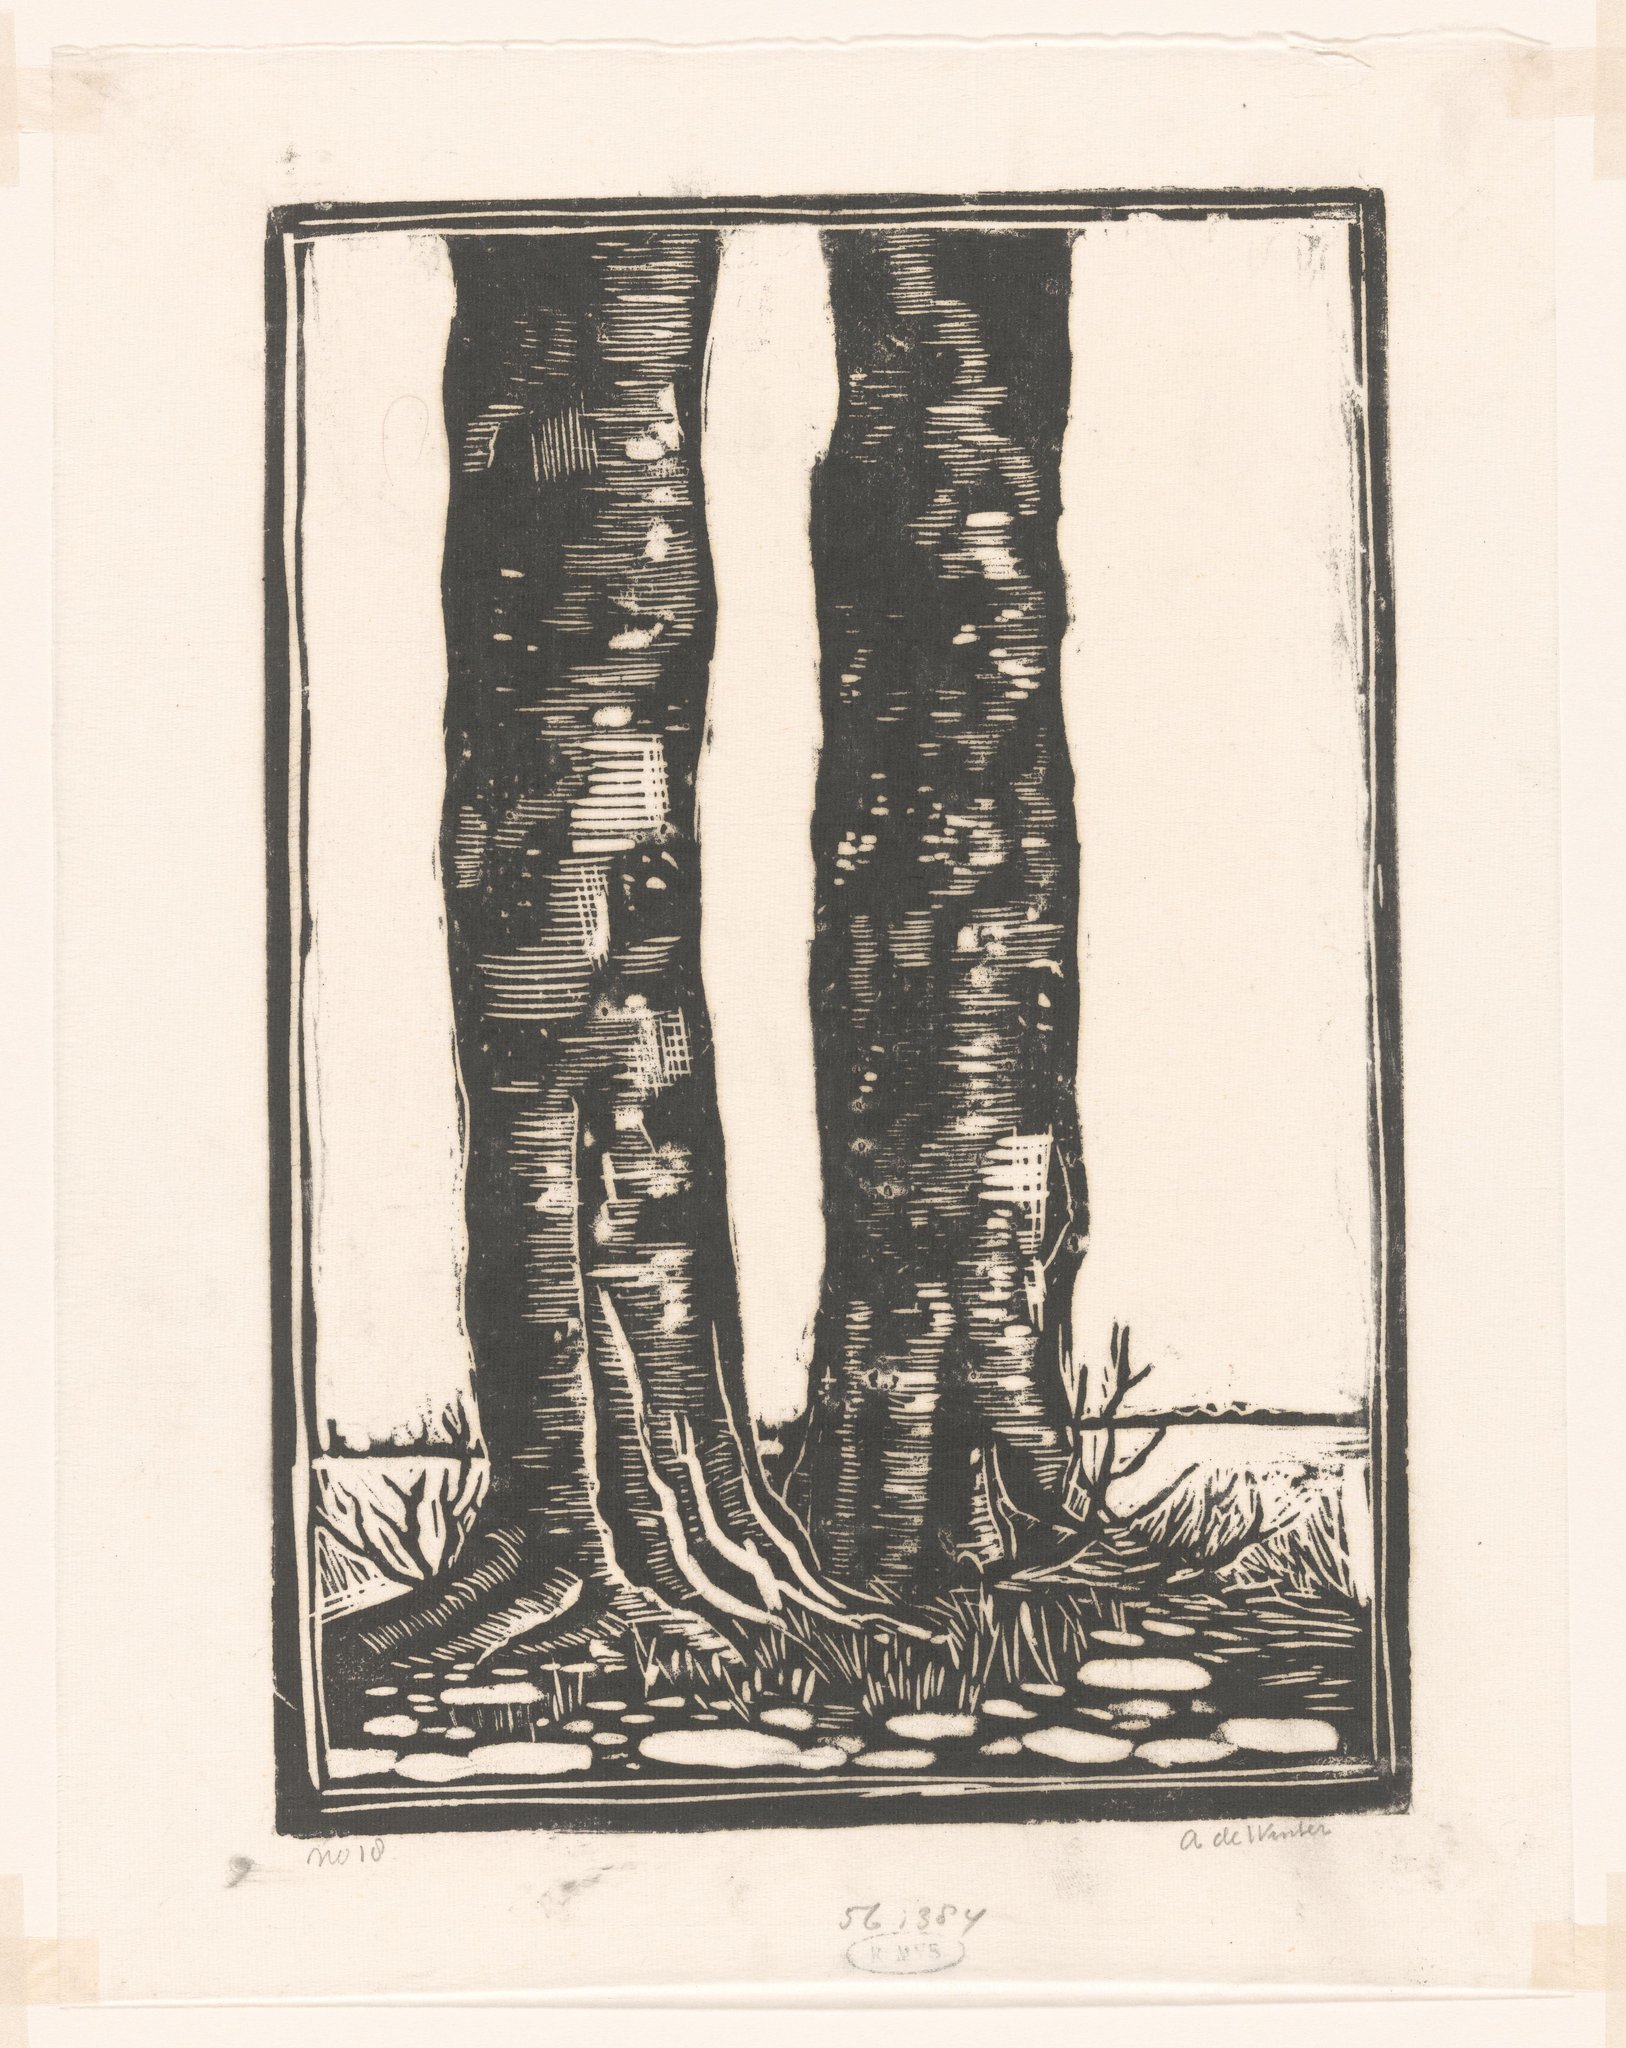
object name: print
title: Twee boomstammen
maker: janus de winter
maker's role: print maker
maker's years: 1882-1951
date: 1892-1951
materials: paper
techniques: linocut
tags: trees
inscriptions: inscription: ‘No 18’, collector's mark: Lugt 2228